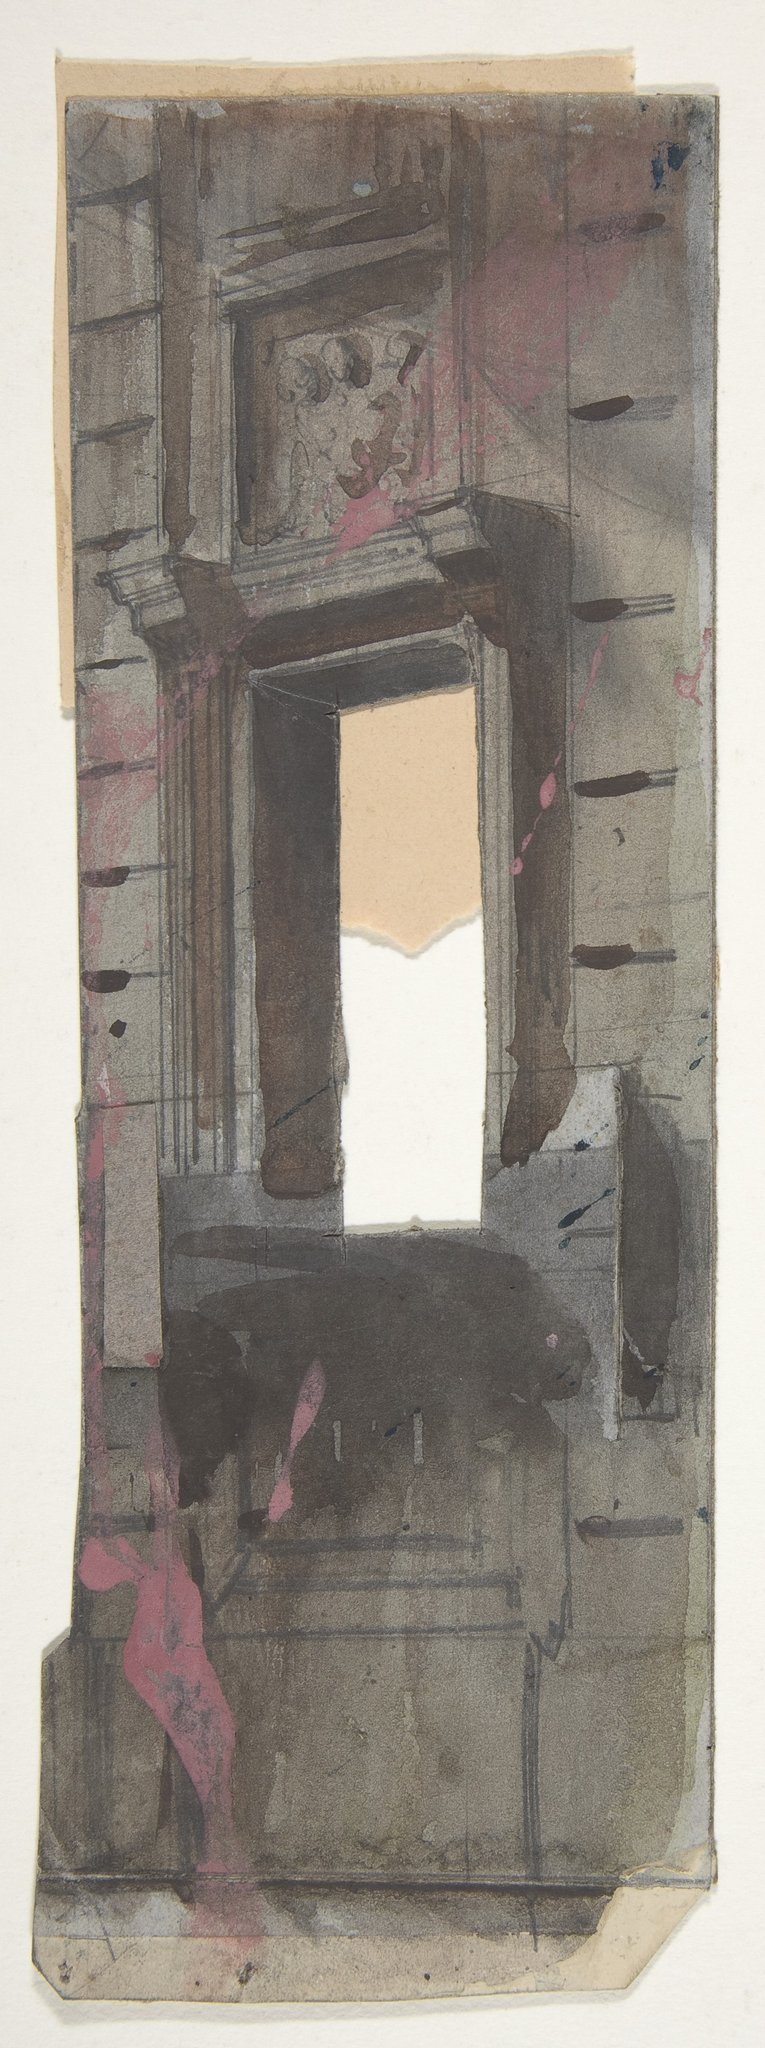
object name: drawing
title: Design for a Stage Set at the Opéra, Paris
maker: eugène cicéri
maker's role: artist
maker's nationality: french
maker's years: 1813-1890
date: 1828-1890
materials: gouache, graphite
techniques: brush, wash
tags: windows,stage design